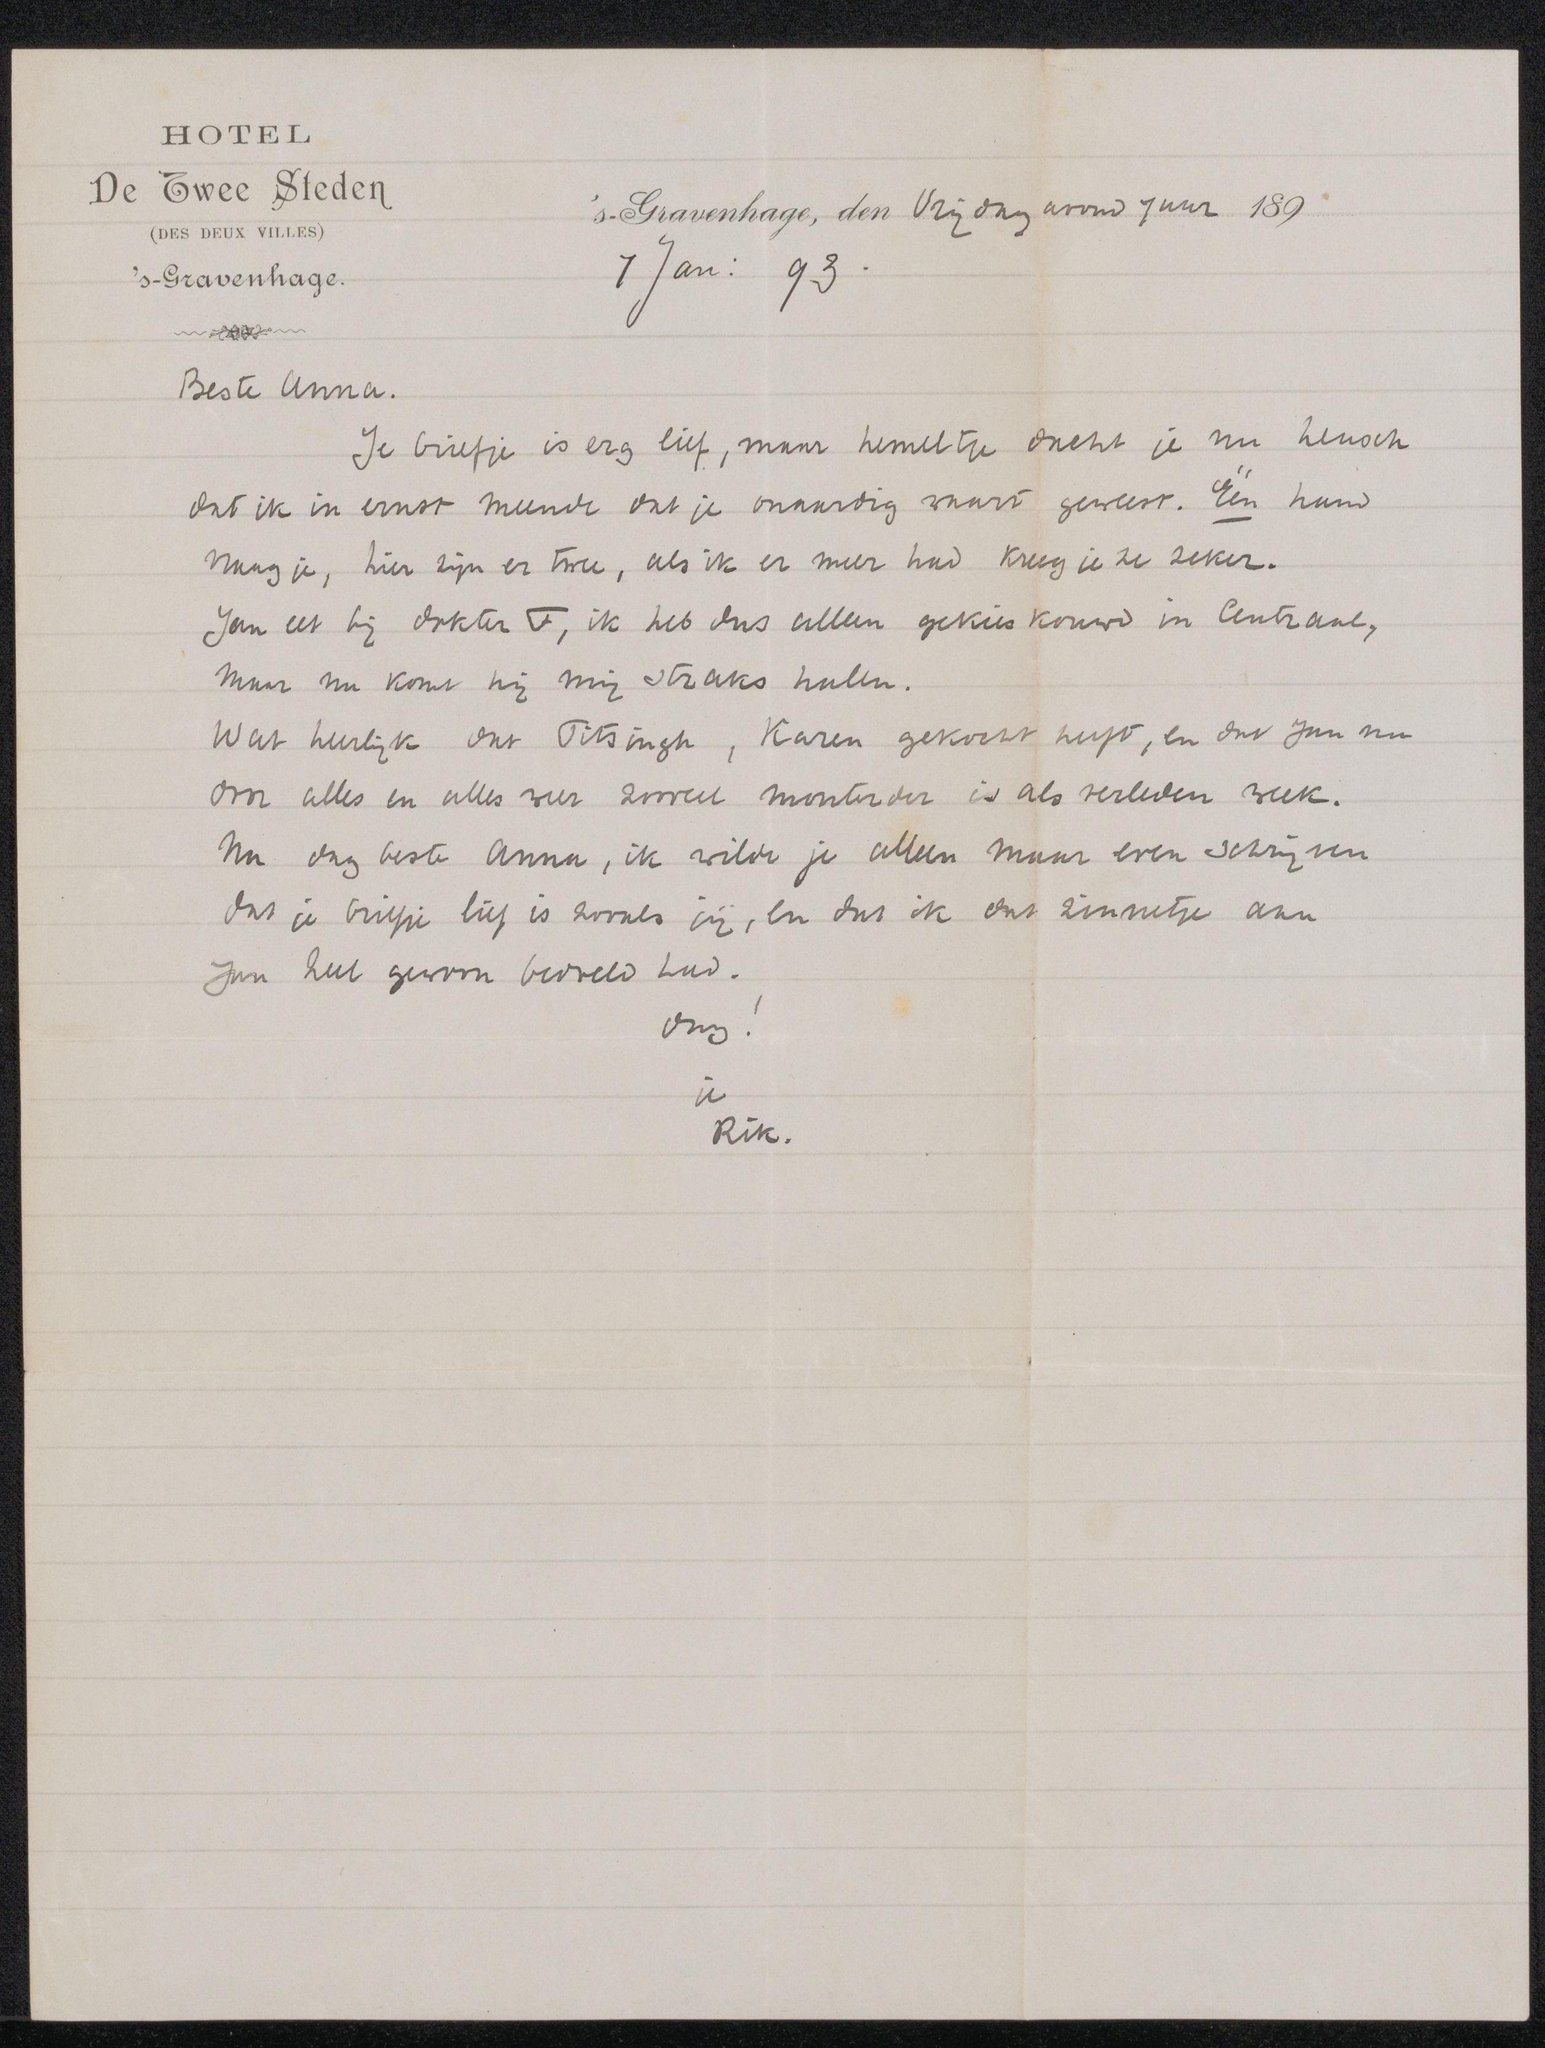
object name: letter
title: Brief aan Anna Dorothea Dirks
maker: richard nicolaüs roland holst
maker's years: 1868-1938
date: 1893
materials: ink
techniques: pen, printing, writing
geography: the hague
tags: dordrecht, amsterdam, painter, print maker, draughtsman, designer, jan veth, artist, anna dorothea dirks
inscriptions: collector's mark: ‘RPK’